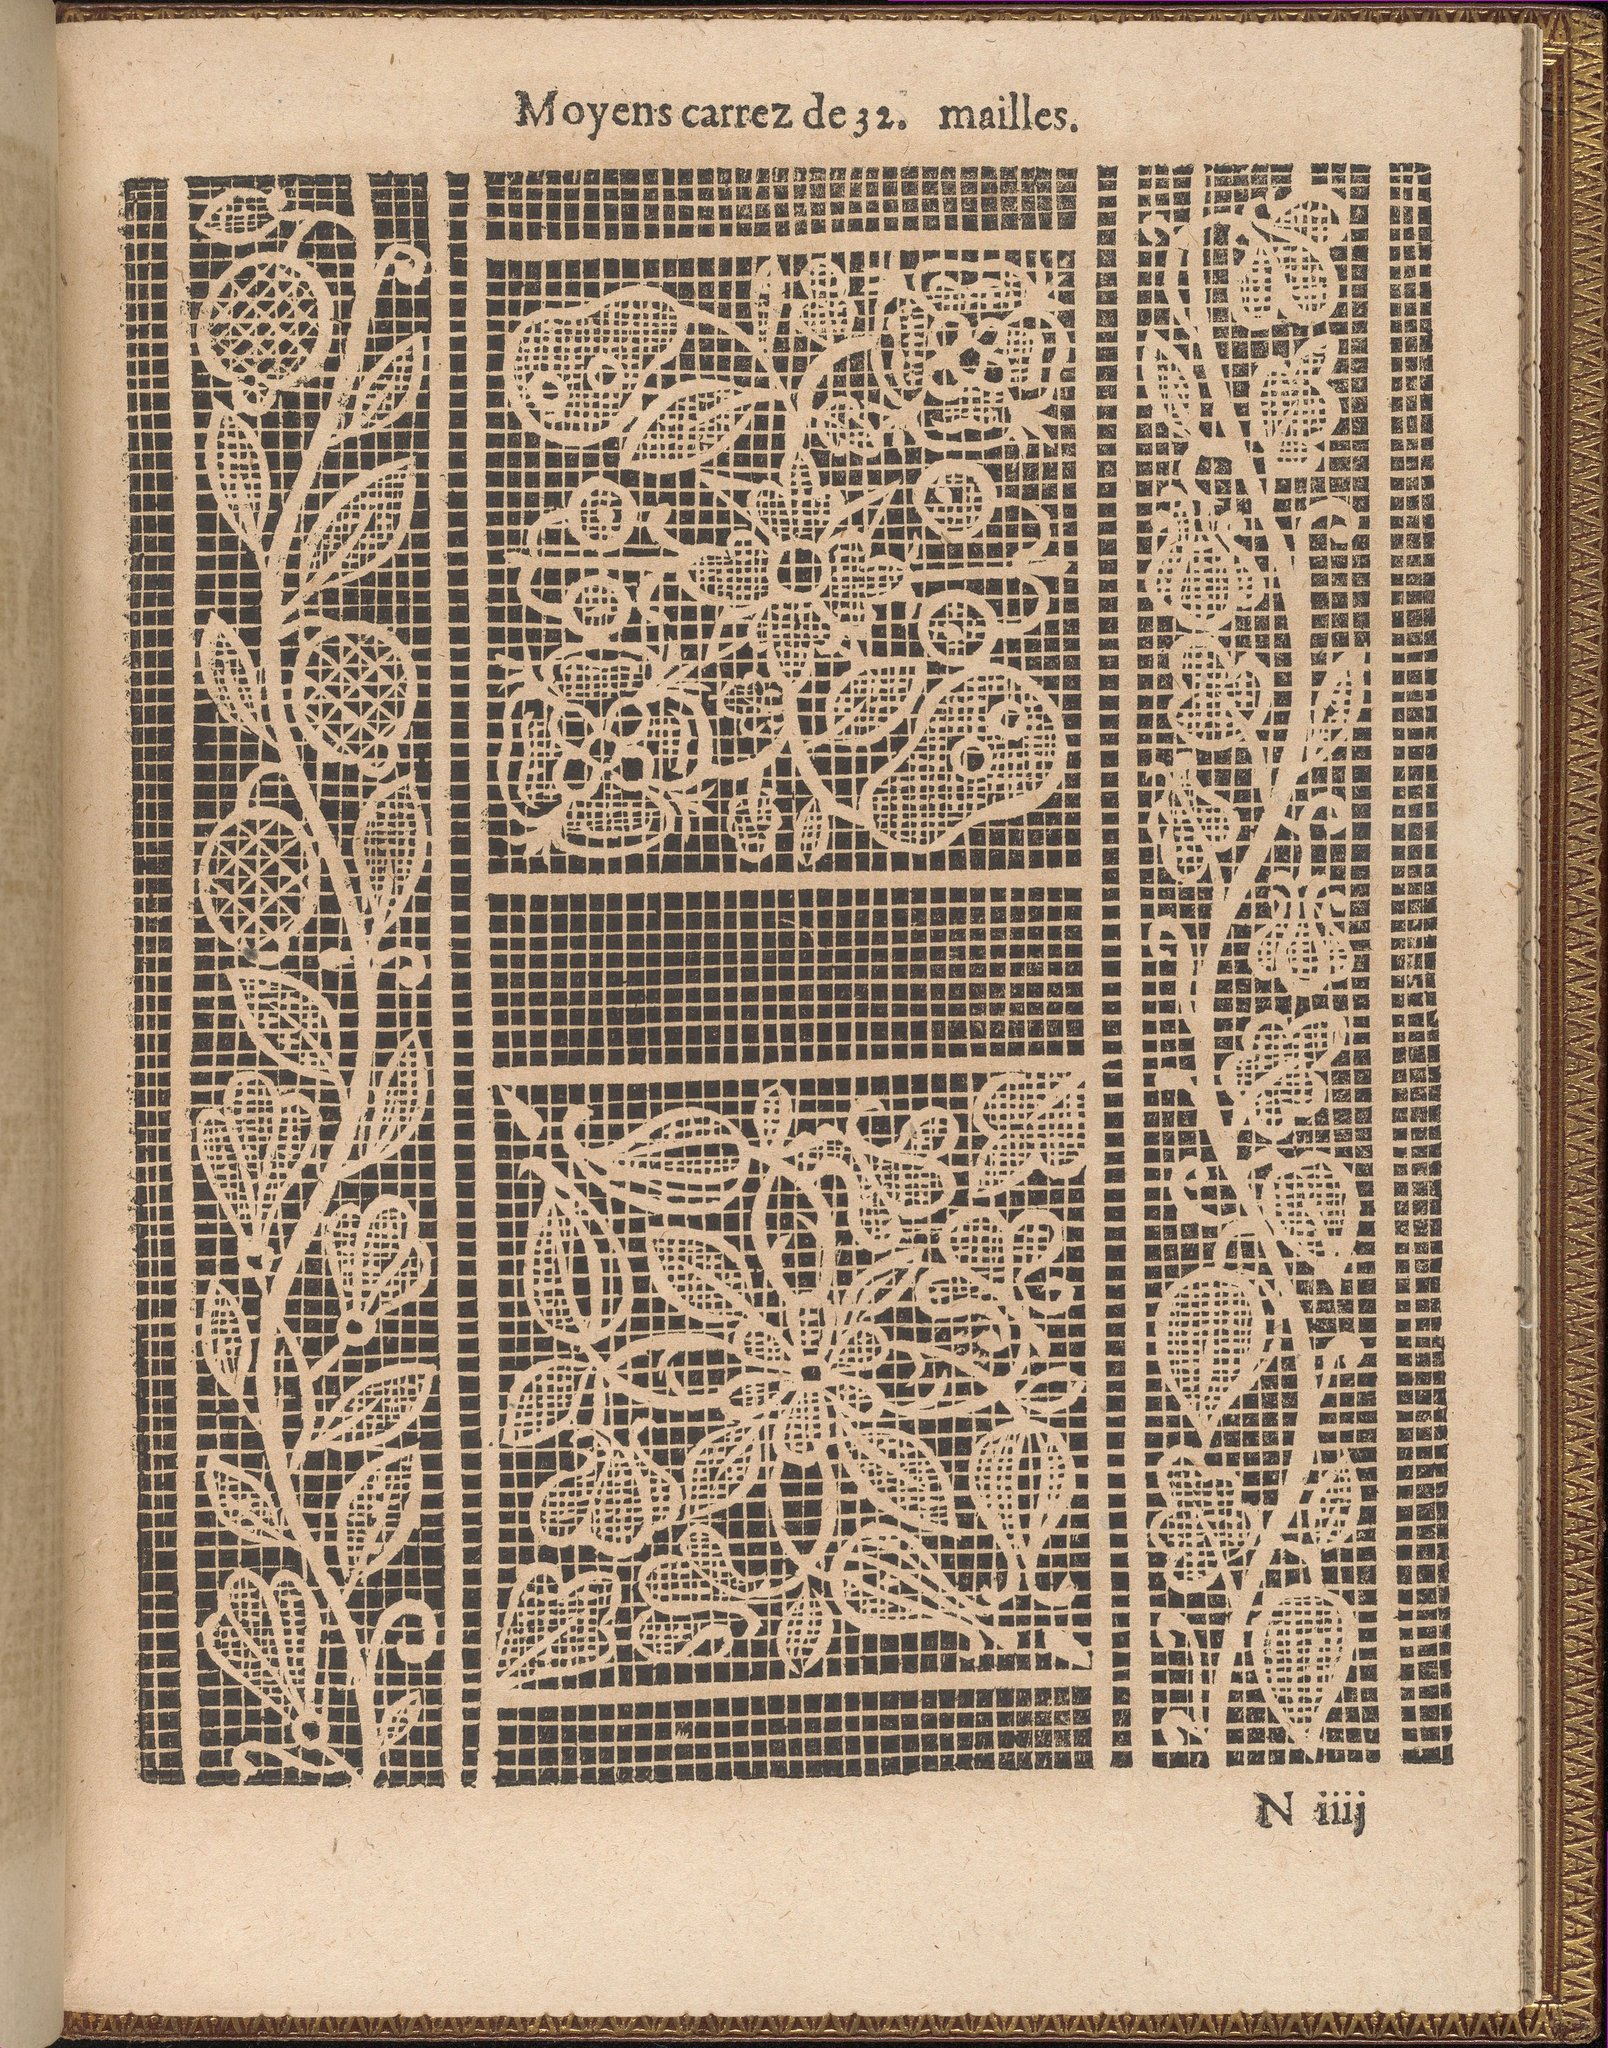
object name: book print ornament architecture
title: La Pratique de l'Aiguille, page 51 (recto)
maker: matthias mignerak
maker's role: author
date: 1605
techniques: woodcut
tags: ornament